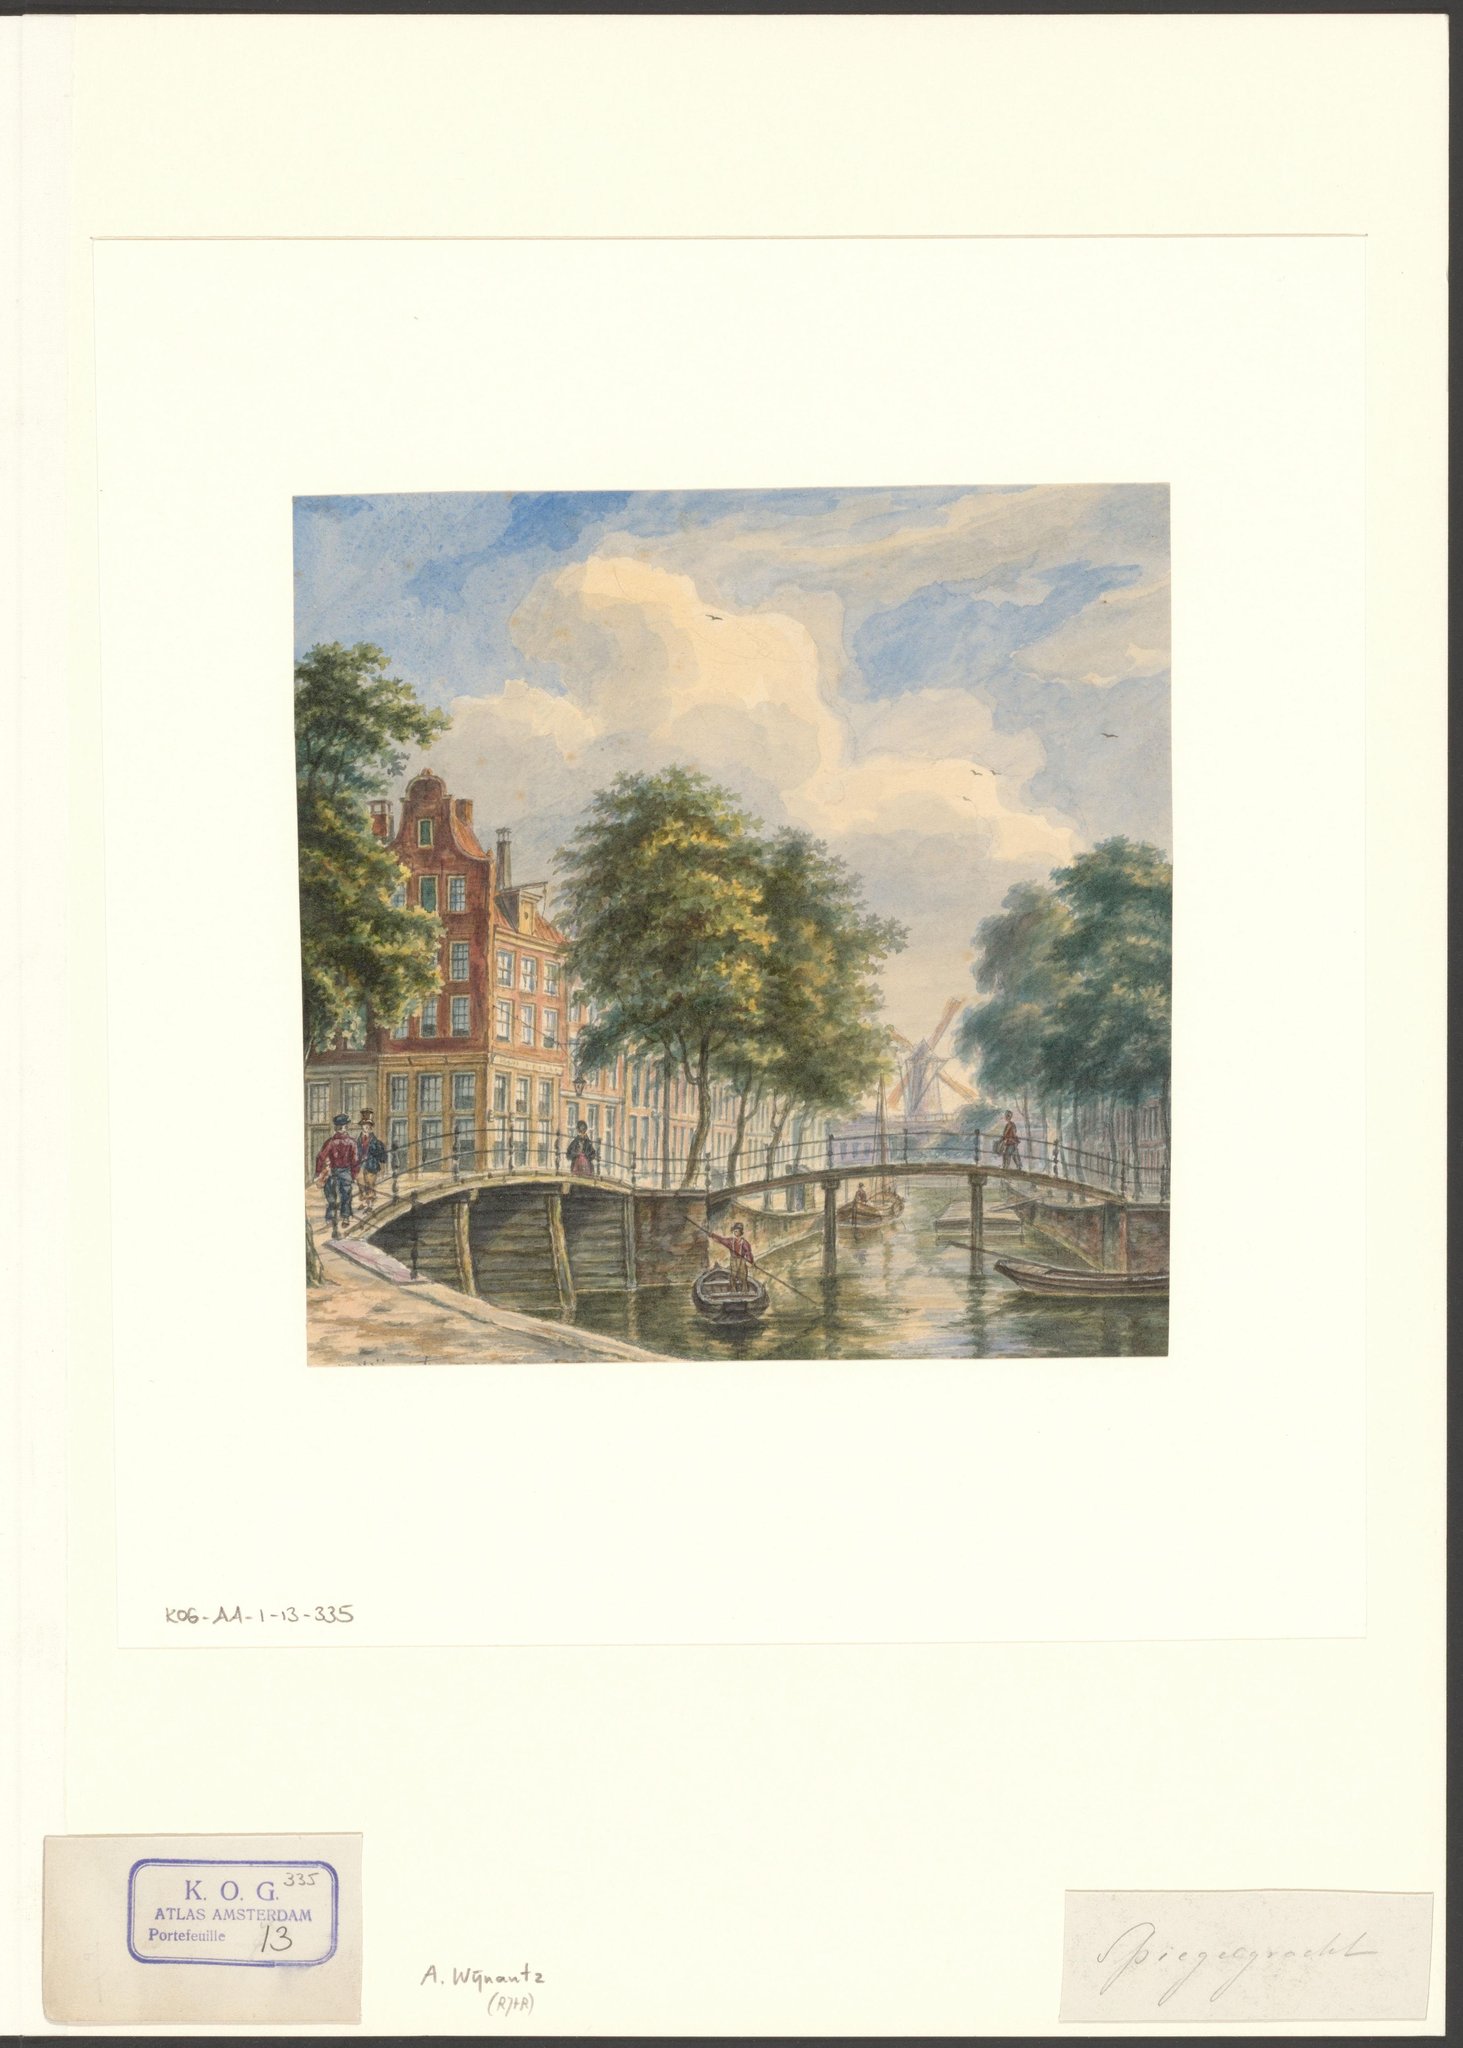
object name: drawing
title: Gezicht op de Prinsengracht, hoek Spiegelgracht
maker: augustus wijnantz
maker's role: draughtsman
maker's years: 1795-1848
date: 1805-1848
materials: ink, paper, pencil, watercolor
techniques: brush, pen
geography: amsterdam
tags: city-view in general; 'veduta', canal, windmill in landscape, bridge in city across river, canal, etc.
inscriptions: collector's mark: ‘13’ Lugt 1641b, inscription: ‘Spiegelgracht / t Amsterdam’, inscription: ‘Port. 13-335’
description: Onderwerpsrubriek binnen de Atlas Amsterdam: Slatuinenpad, Sloterkade, Slootstraat, Slijkstraat, Snoekjesgracht, Sophiapark, Spaarndammerdijk, Spiegelgracht, Spinhuissteeg, Spui, Spuistraat (ook lage Erf), Staalstraat, Stadhouderskade, Steenpad, Stroomarkt.